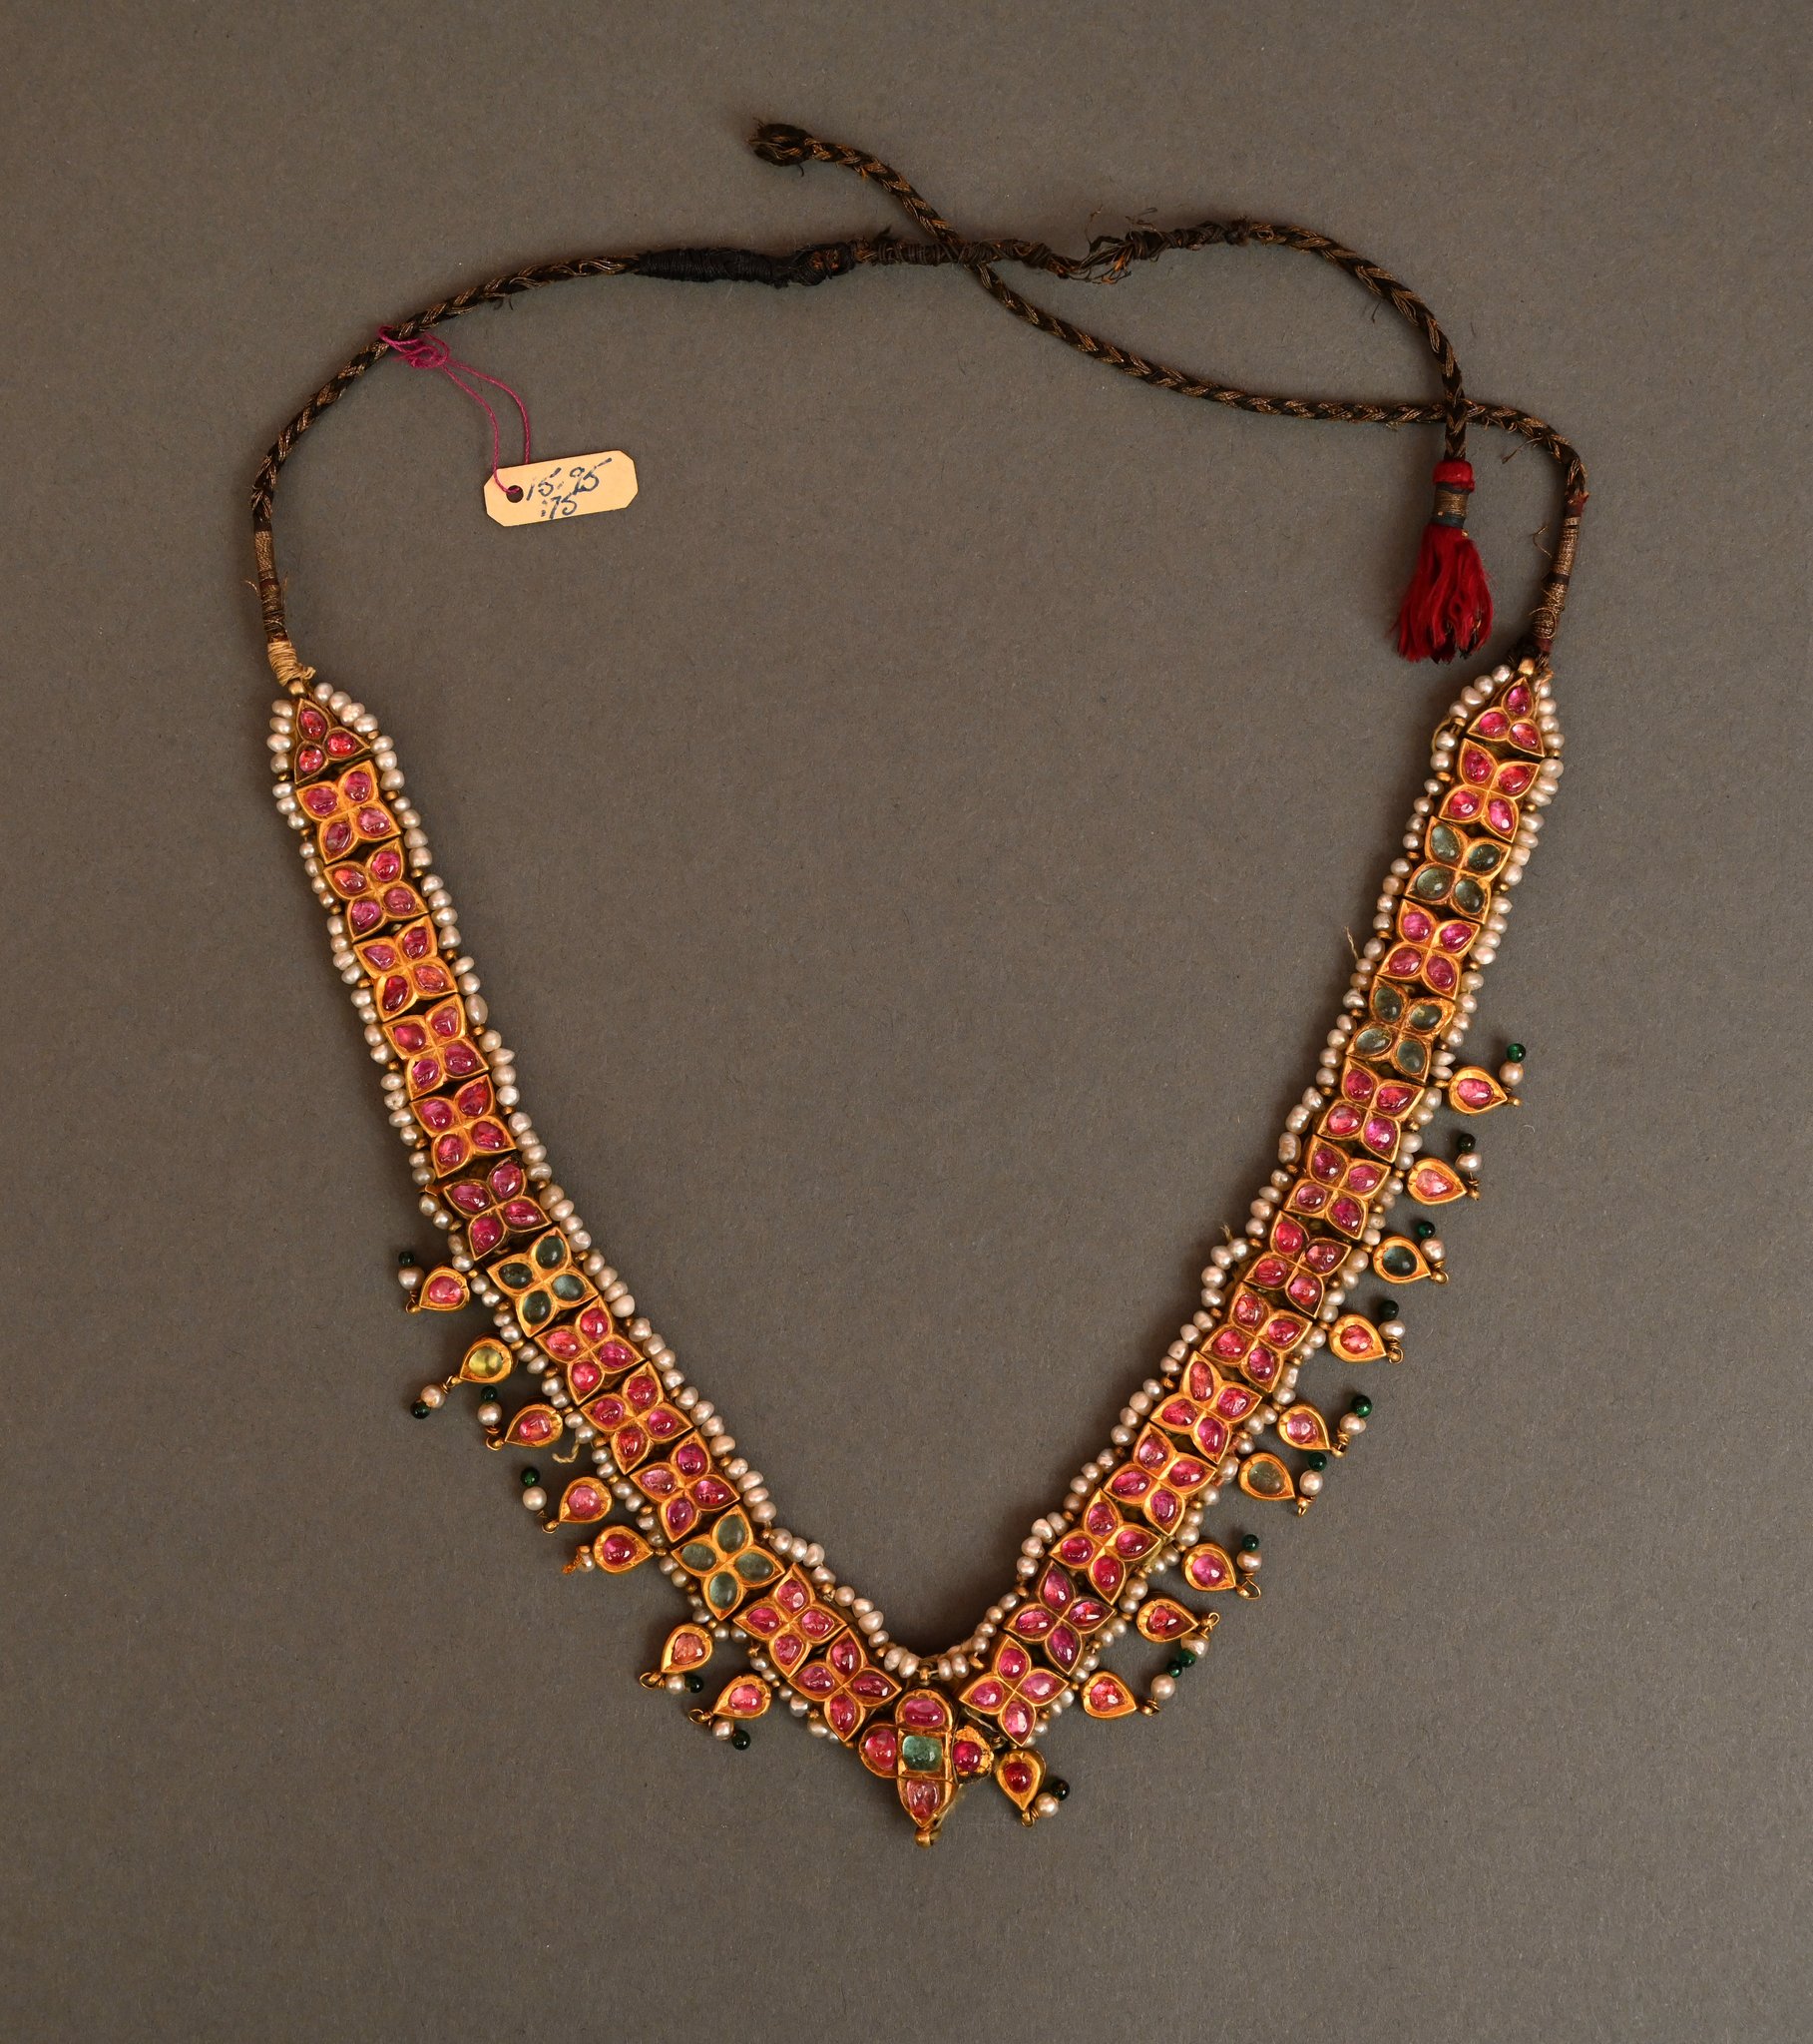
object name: necklace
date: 1701-1900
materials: enamel, glass, gold, pearl, stone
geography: india